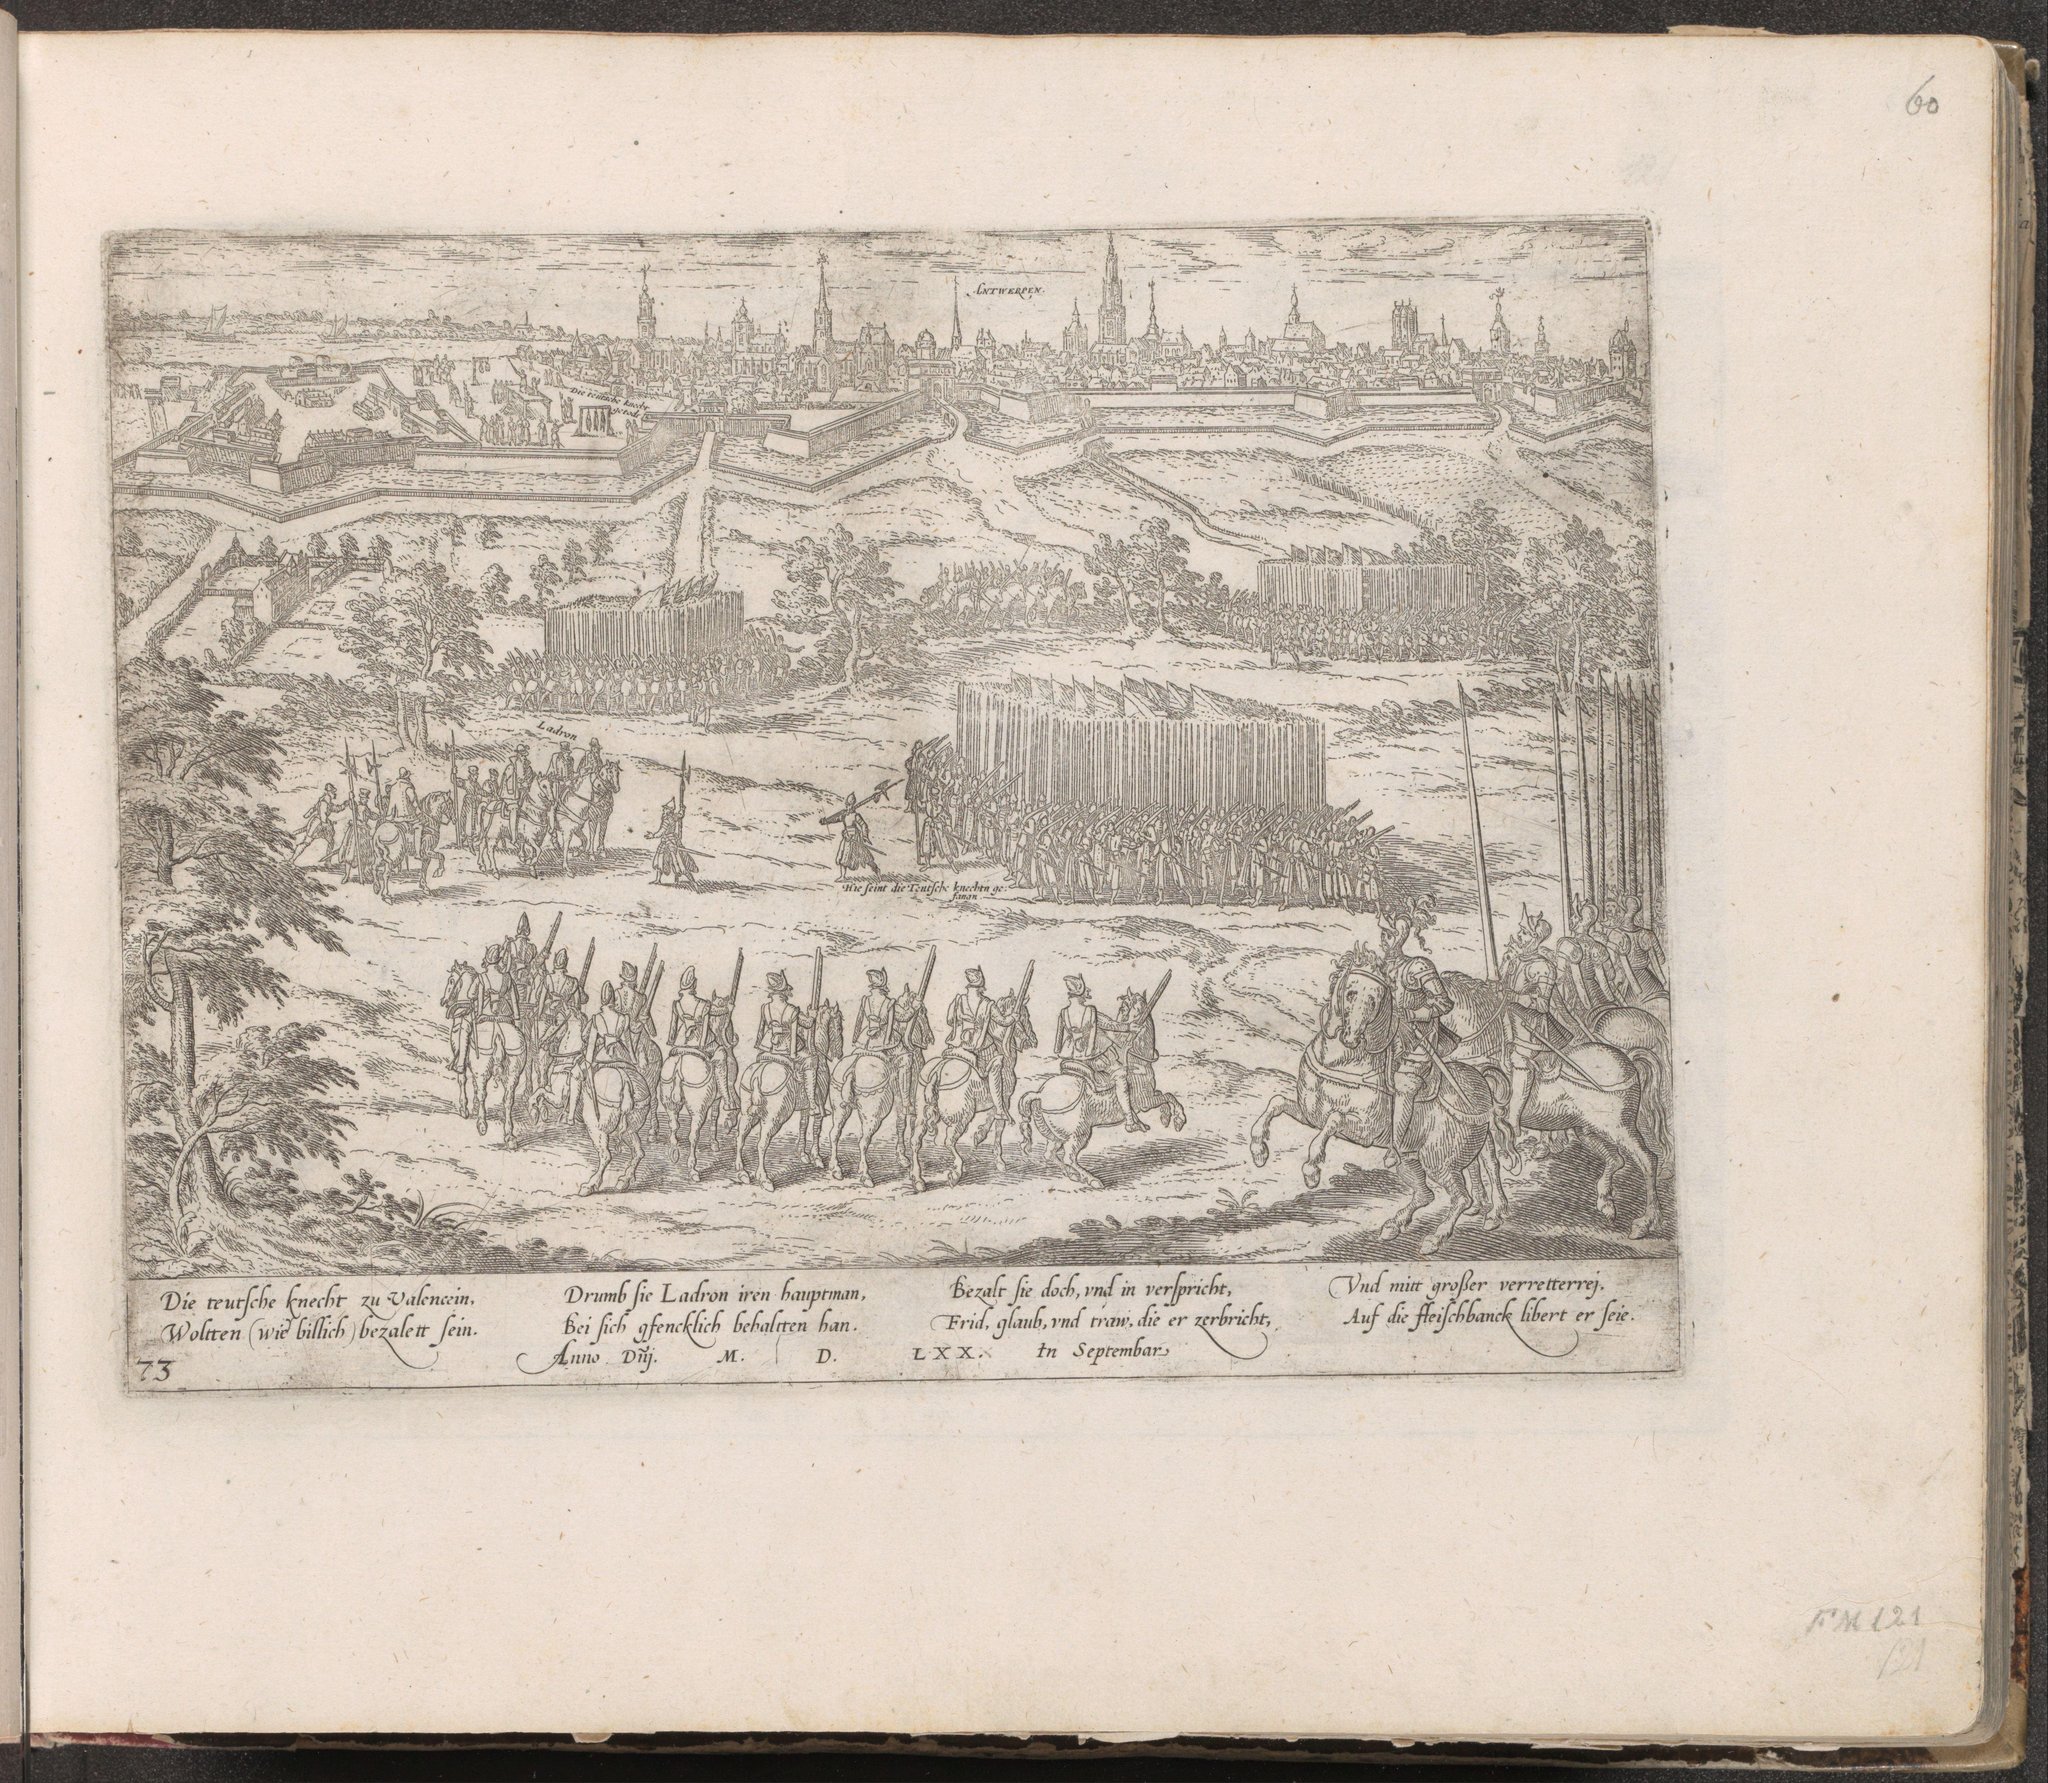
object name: print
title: Verraad van Ladron, 1570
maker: frans hogenberg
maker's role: print maker, publisher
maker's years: 1538-1590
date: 1570-1572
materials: paper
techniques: etching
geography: cologne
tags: alberik graaf van ladron, citadel van antwerpen (16e eeuw), tachtigjarige oorlog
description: Gevangenneming van de Duitse soldaten buiten Antwerpen, op last van graaf Alberik van Ladron die eerder door deze soldaten was gegijzeld, september 1570. De Duitse huurlingen worden omsingeld door Spaanse troepen. Op de achtergrond de stad Antwerpen met links een kleine scène van de terechtstelling van enkele soldaten in de citadel. Met onderschrift van 8 regels in het Duits. Linksonder genummerd: 73. De prent maakt deel uit van een album.